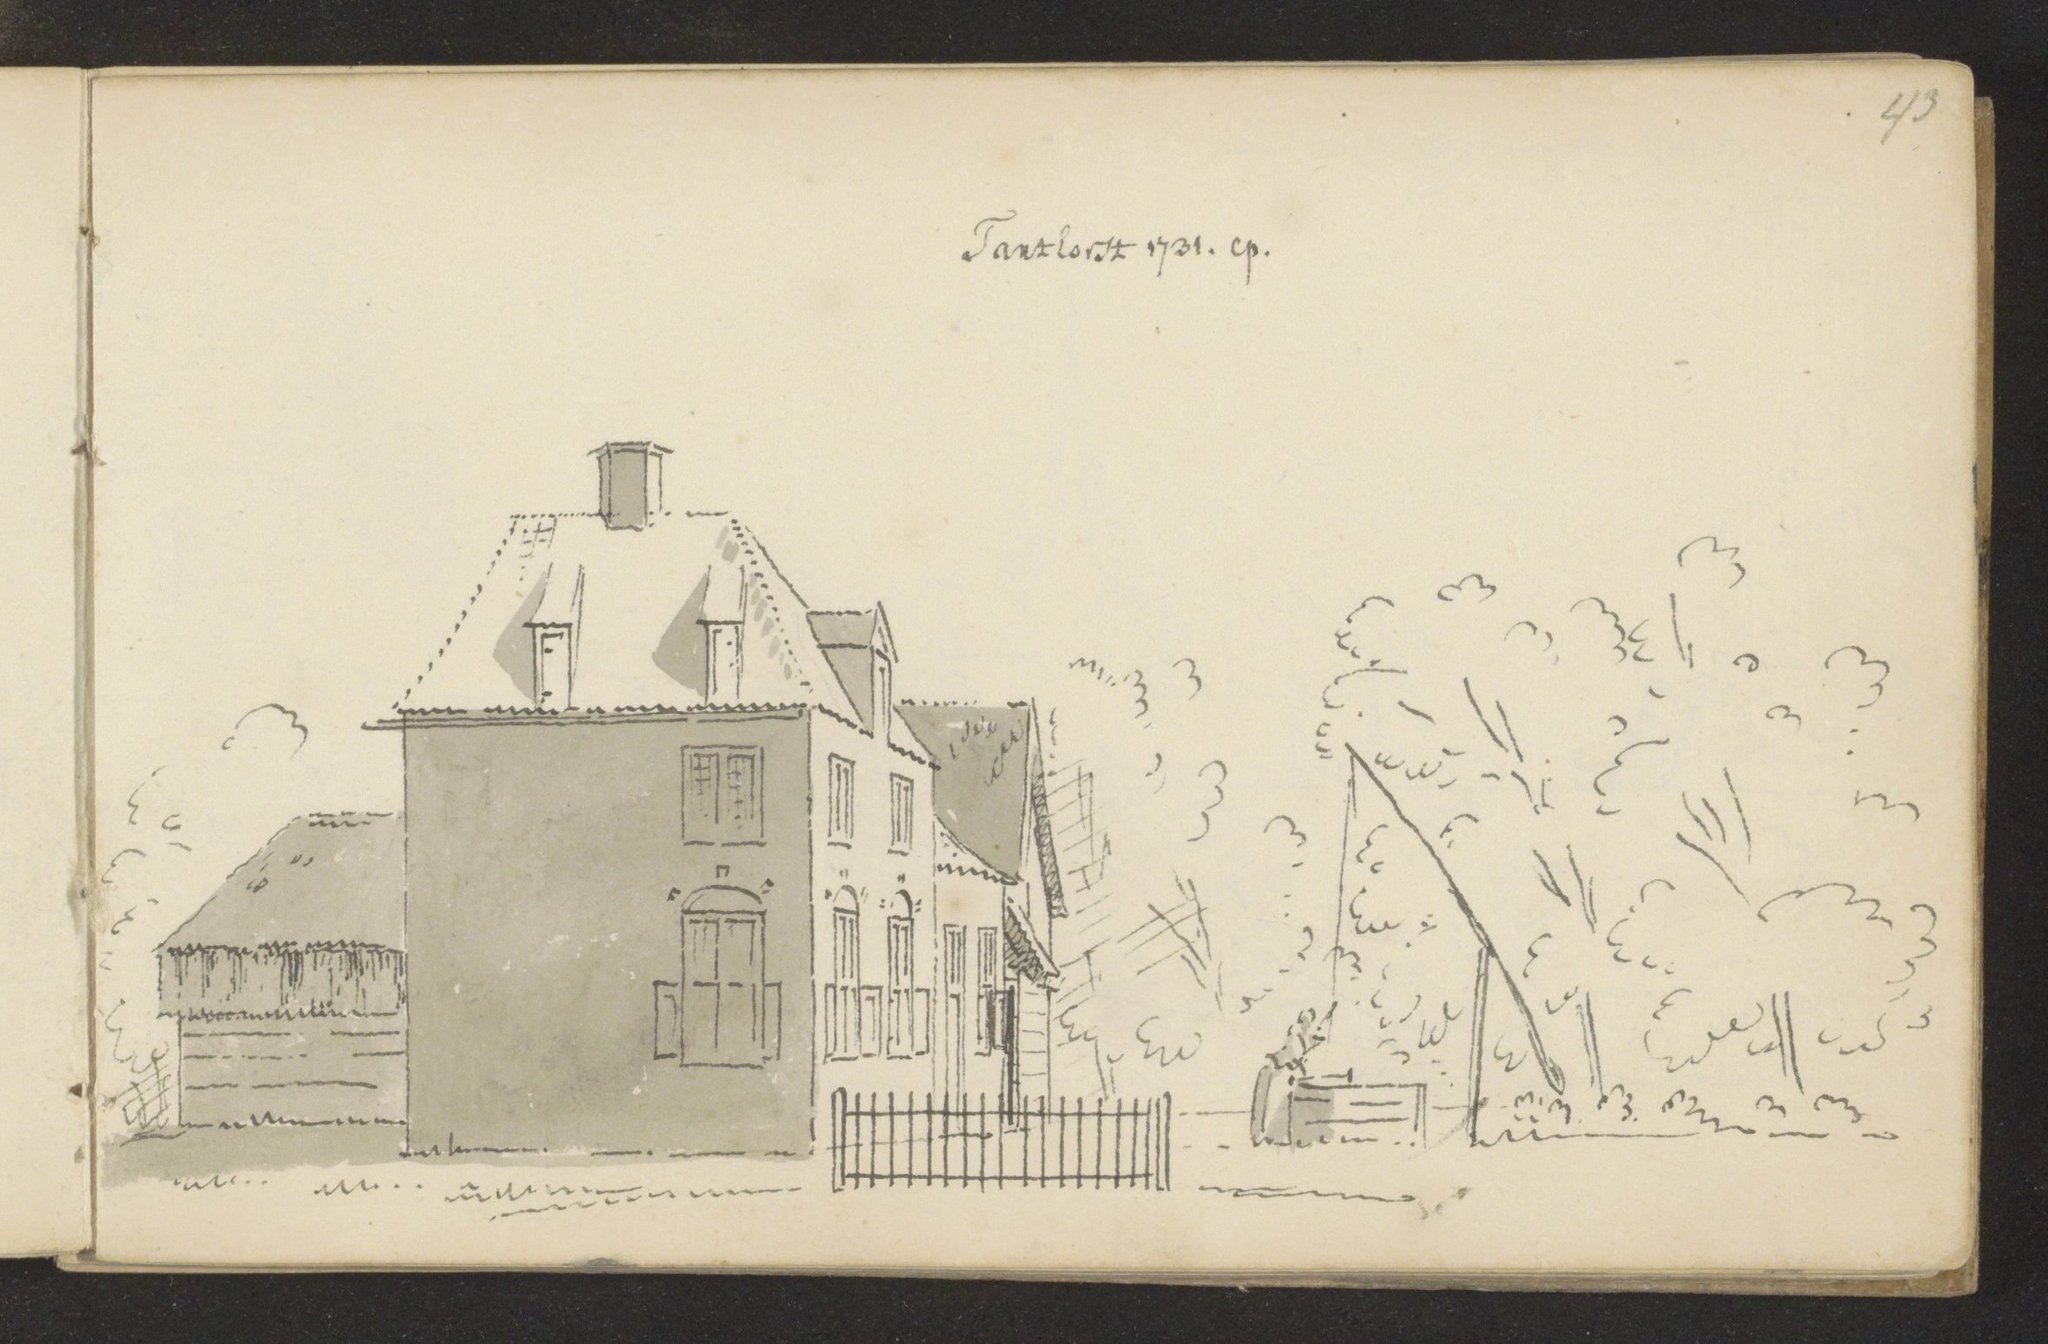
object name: sketchbook leaf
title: Boerderij Tarthorst te Wageningen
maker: abraham de haen (ii)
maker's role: draughtsman, print maker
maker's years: 1707-1748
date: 1731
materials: ink, paper, pencil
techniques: brush, pen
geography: wageningen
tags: farm (building)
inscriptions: date and inscription: ‘Tarthorst 1731.cp.’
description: Blad 43 recto uit een schetsboek met 78 bladen.